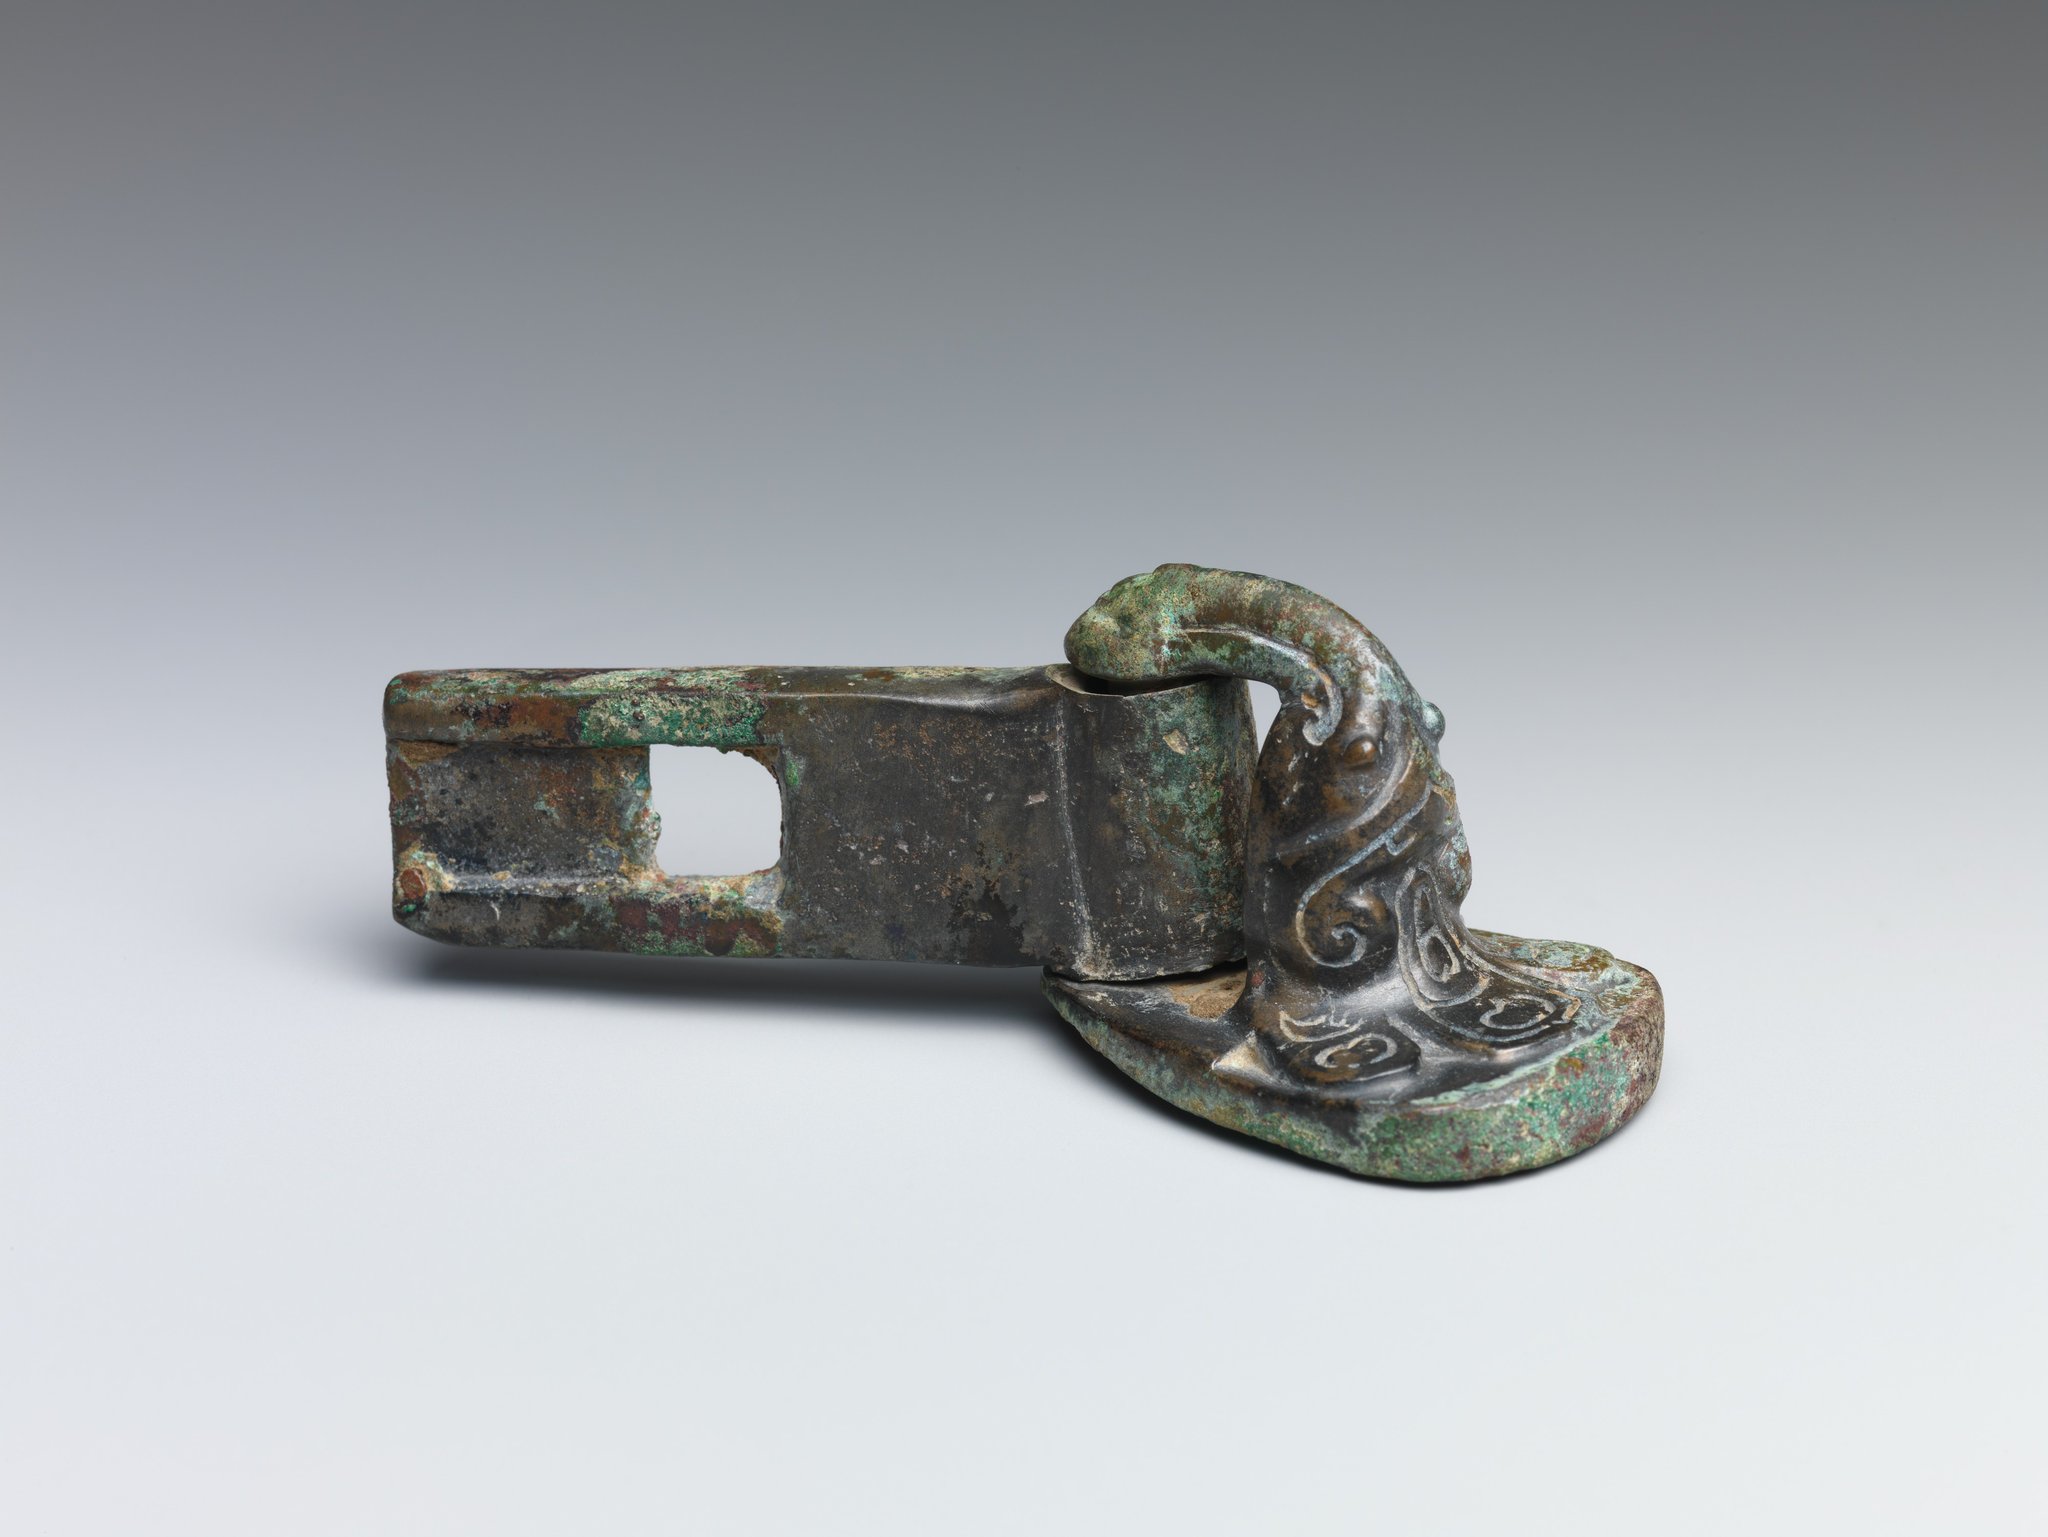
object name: axle pin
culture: chinese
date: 1046-771 BCE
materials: bronze